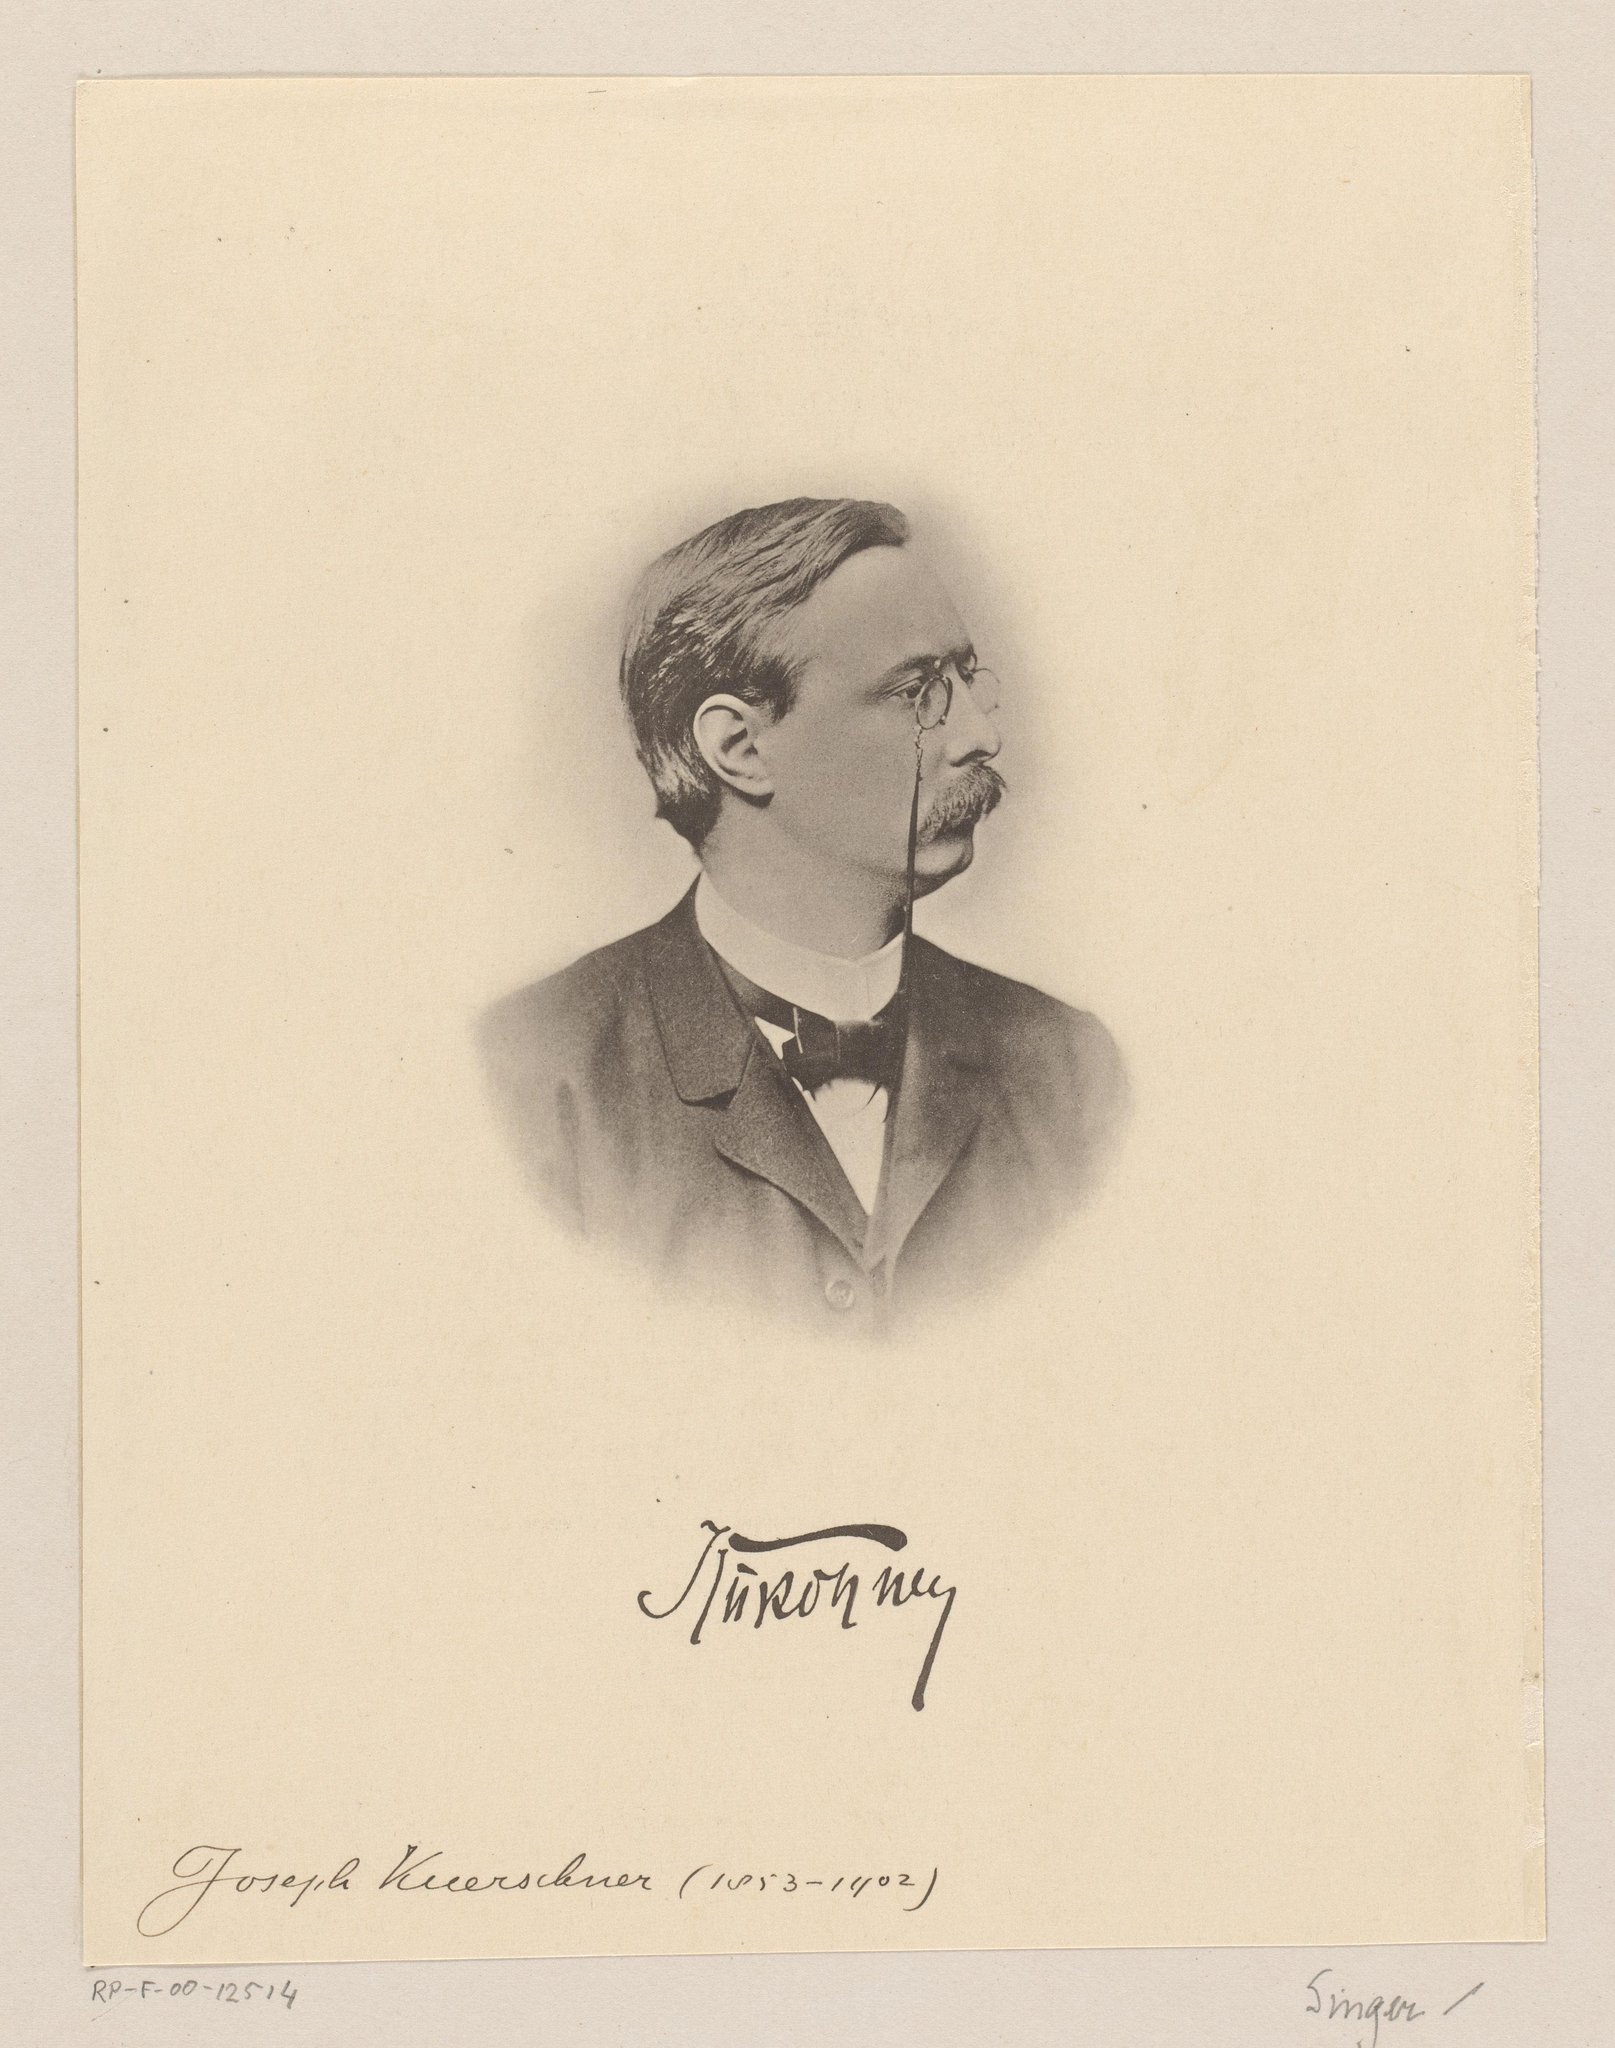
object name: photomechanical print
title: Portret van van Joseph Kürschner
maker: Anonymous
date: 1900-1902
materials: paper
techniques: photograph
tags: historical persons